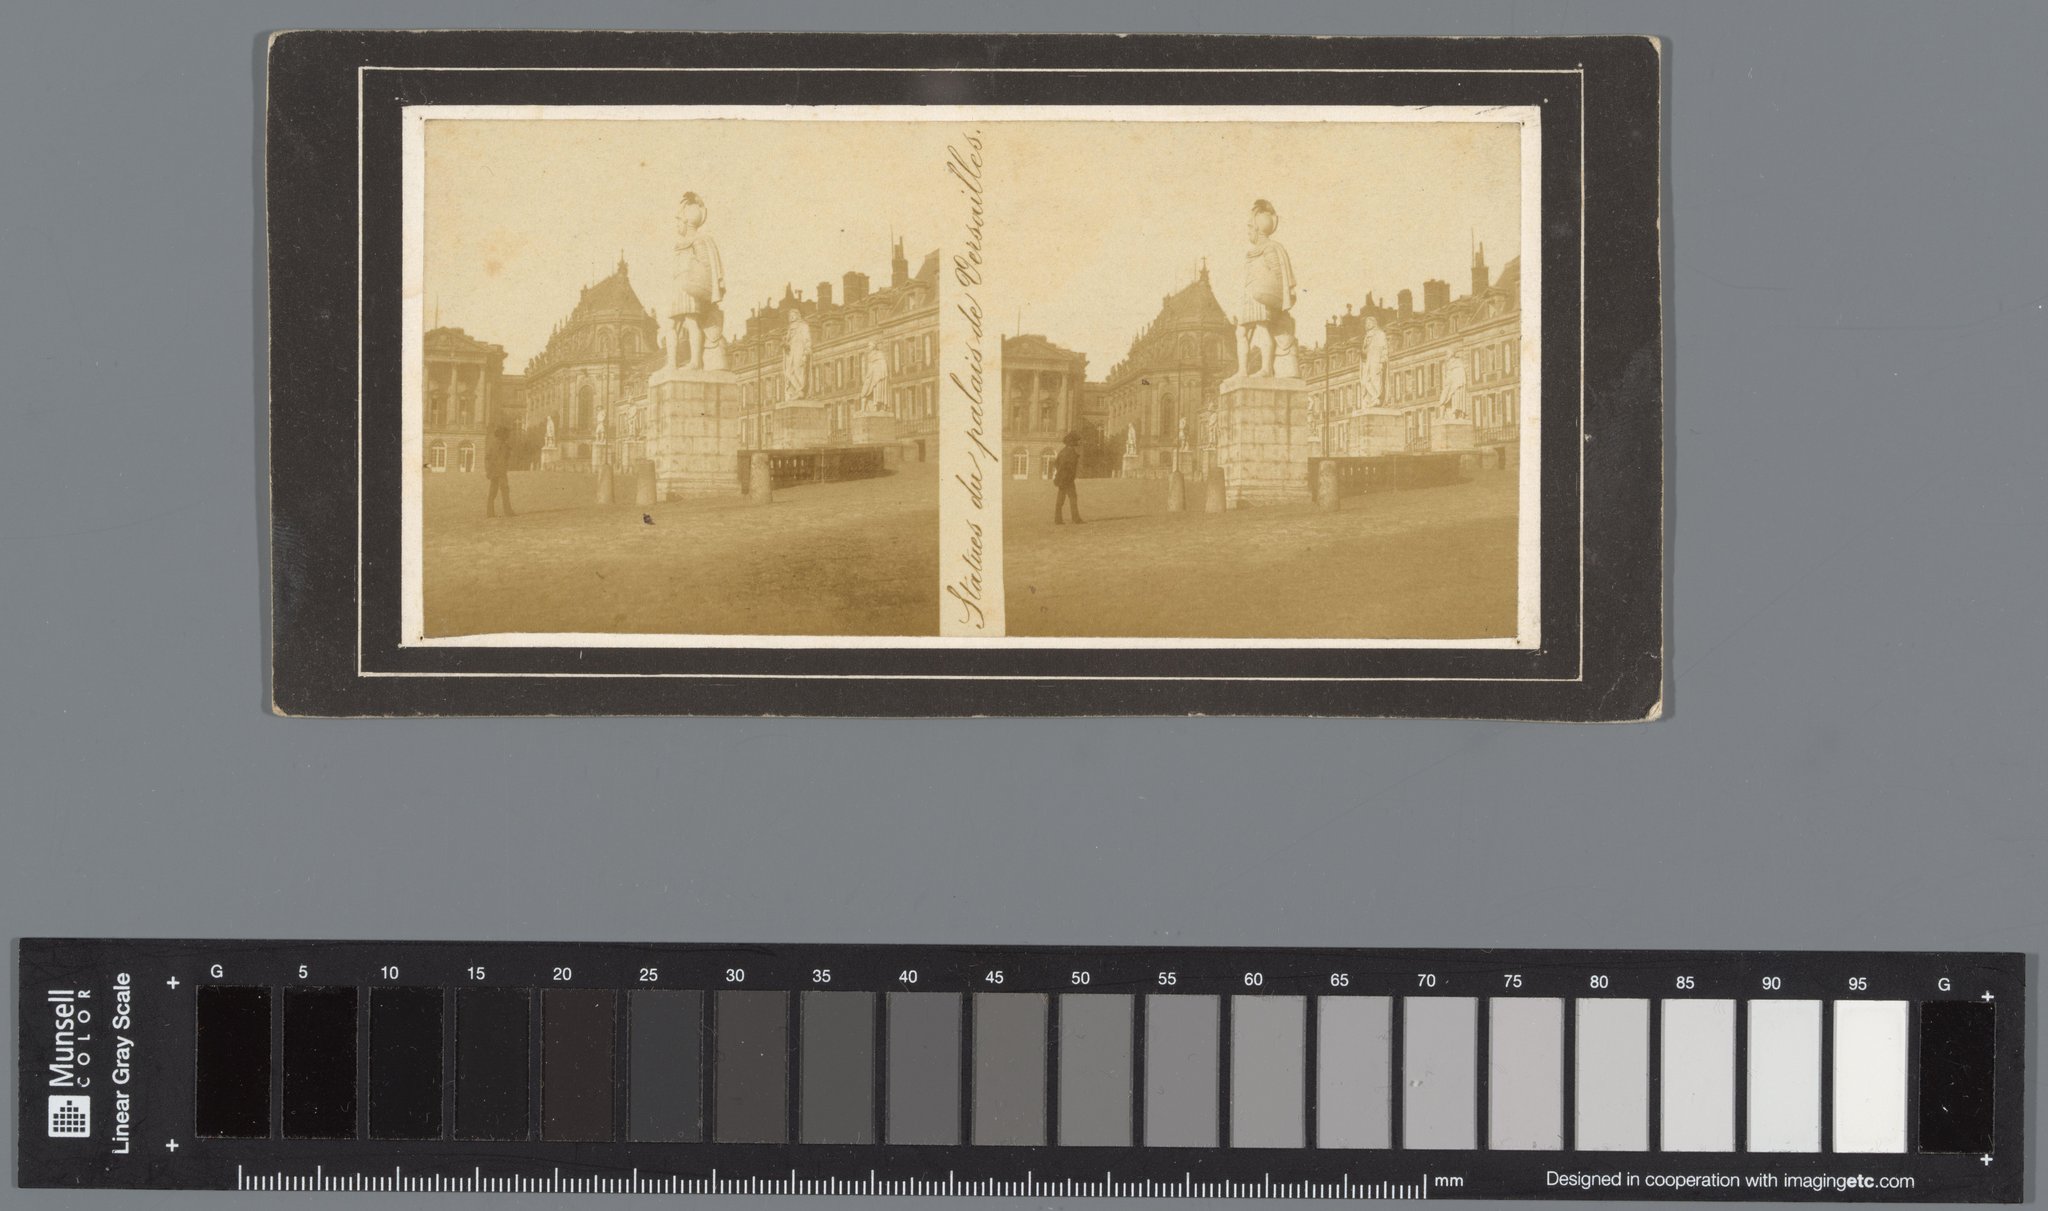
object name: stereograph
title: Gezicht op het plein voor het Paleis van Versailles met standbeelden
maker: Anonymous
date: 1850-1880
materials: cardboard, photographic support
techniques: albumen print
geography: versailles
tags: monument, statue, courtyard